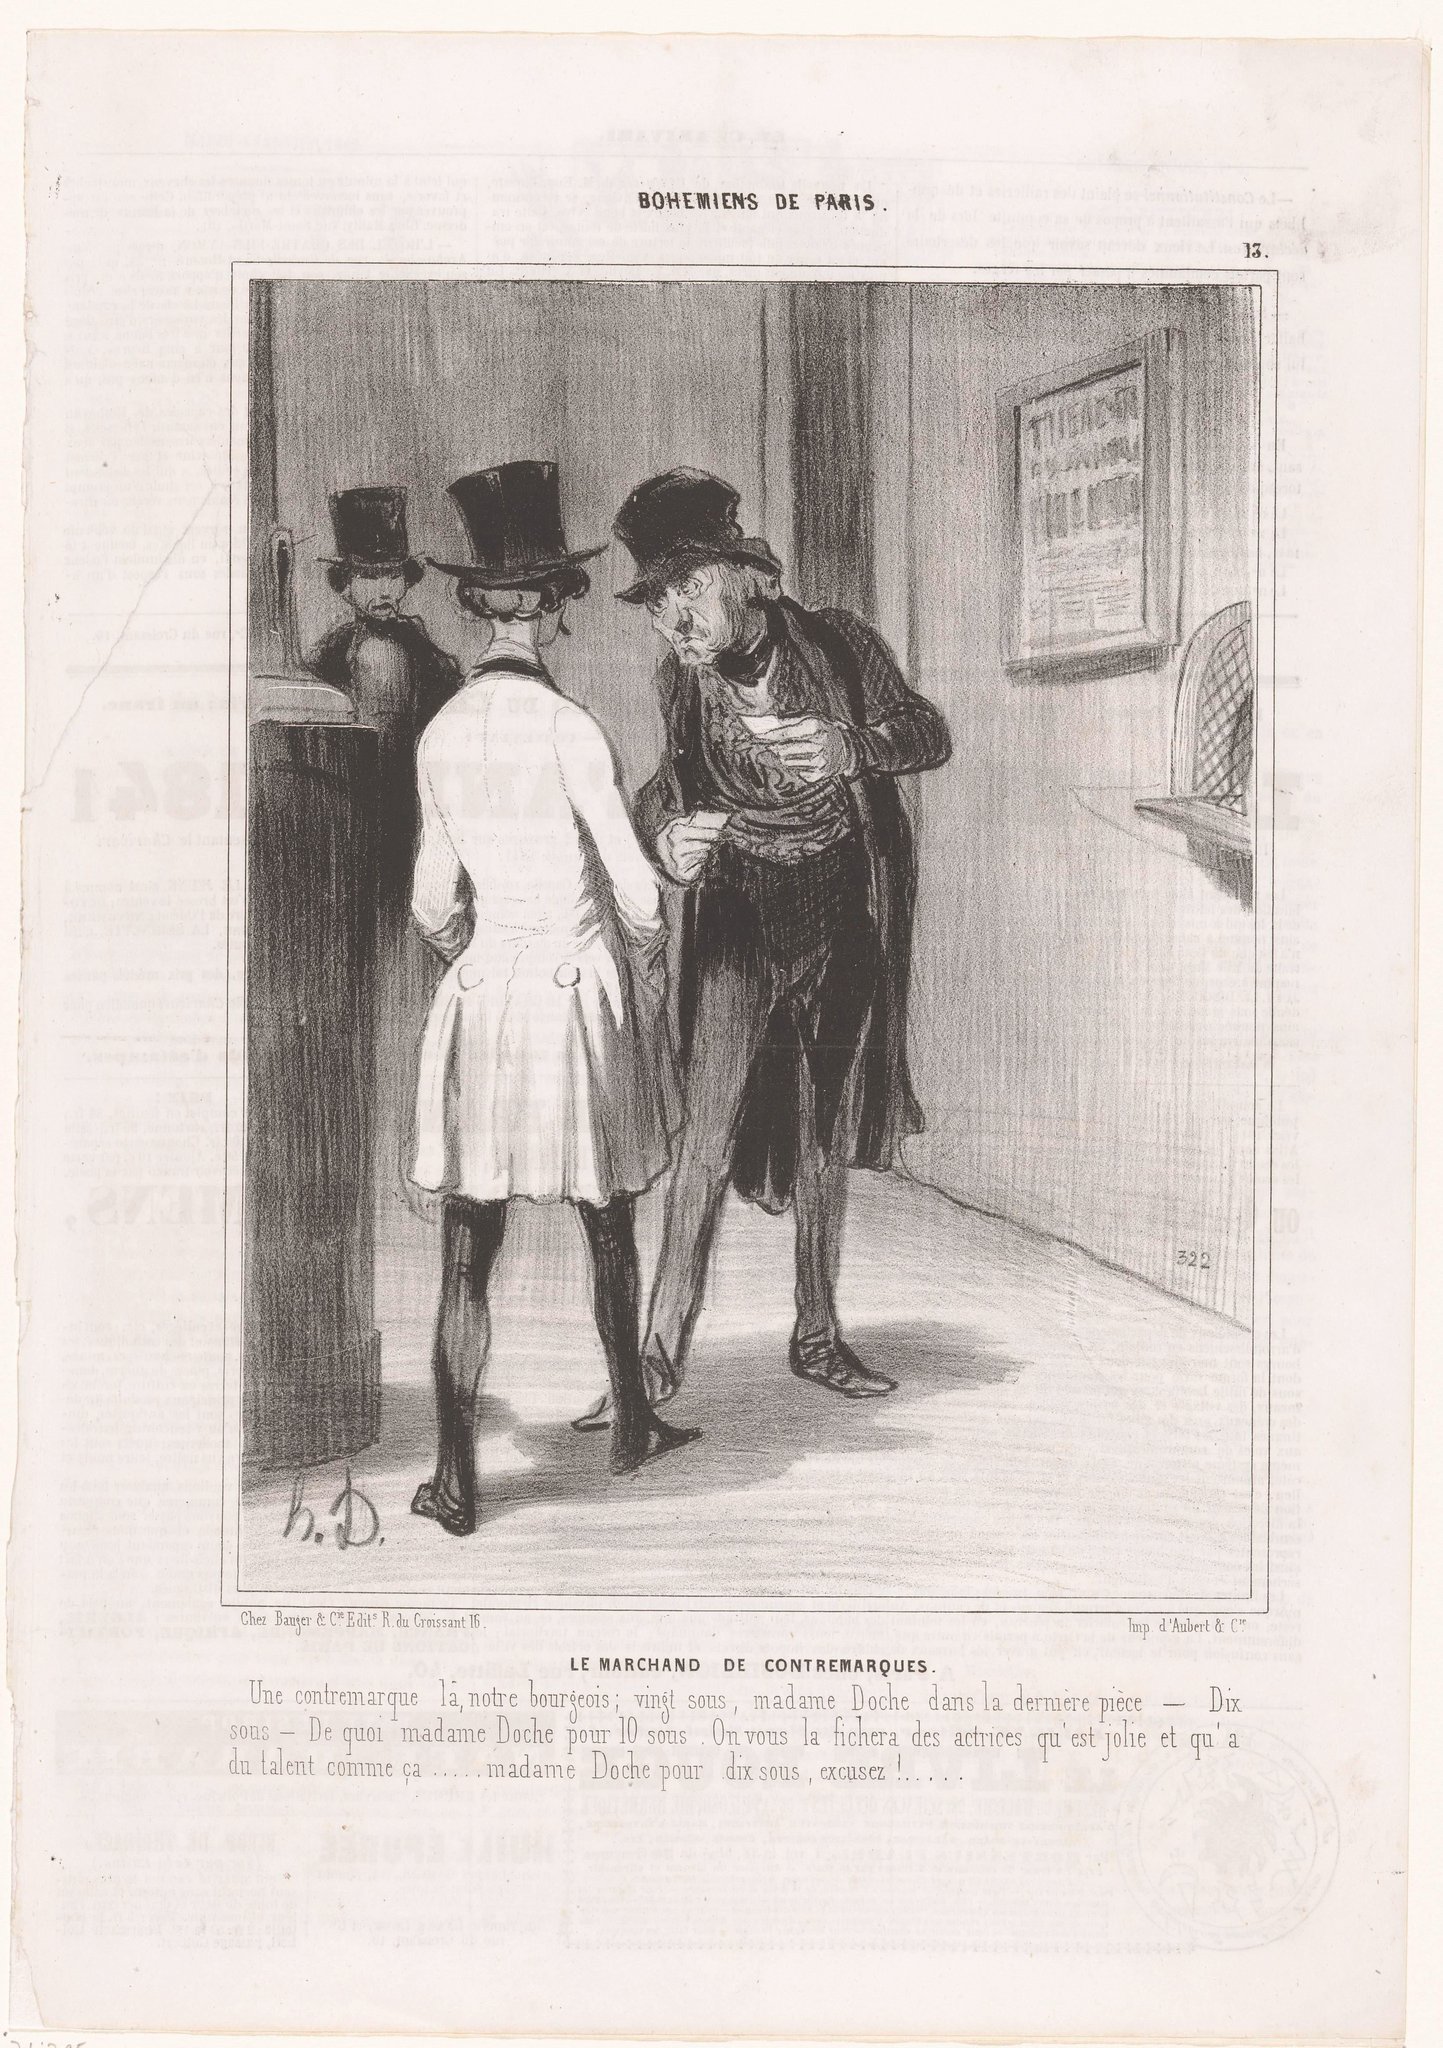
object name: cartoon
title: Bohémiens de Paris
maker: honoré daumier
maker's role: draughtsman, painter, print maker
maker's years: 1808-1879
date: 1842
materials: paper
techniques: letterpress printing, lithograph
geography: paris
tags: caricatures (human types), theatre (building), street-trader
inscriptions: stamp: ‘Timbre Royal Seine, 3 c.’, collector's mark: Lugt 2228a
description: Prent mogelijk uit: Le Charivari, 4 januari 1842.